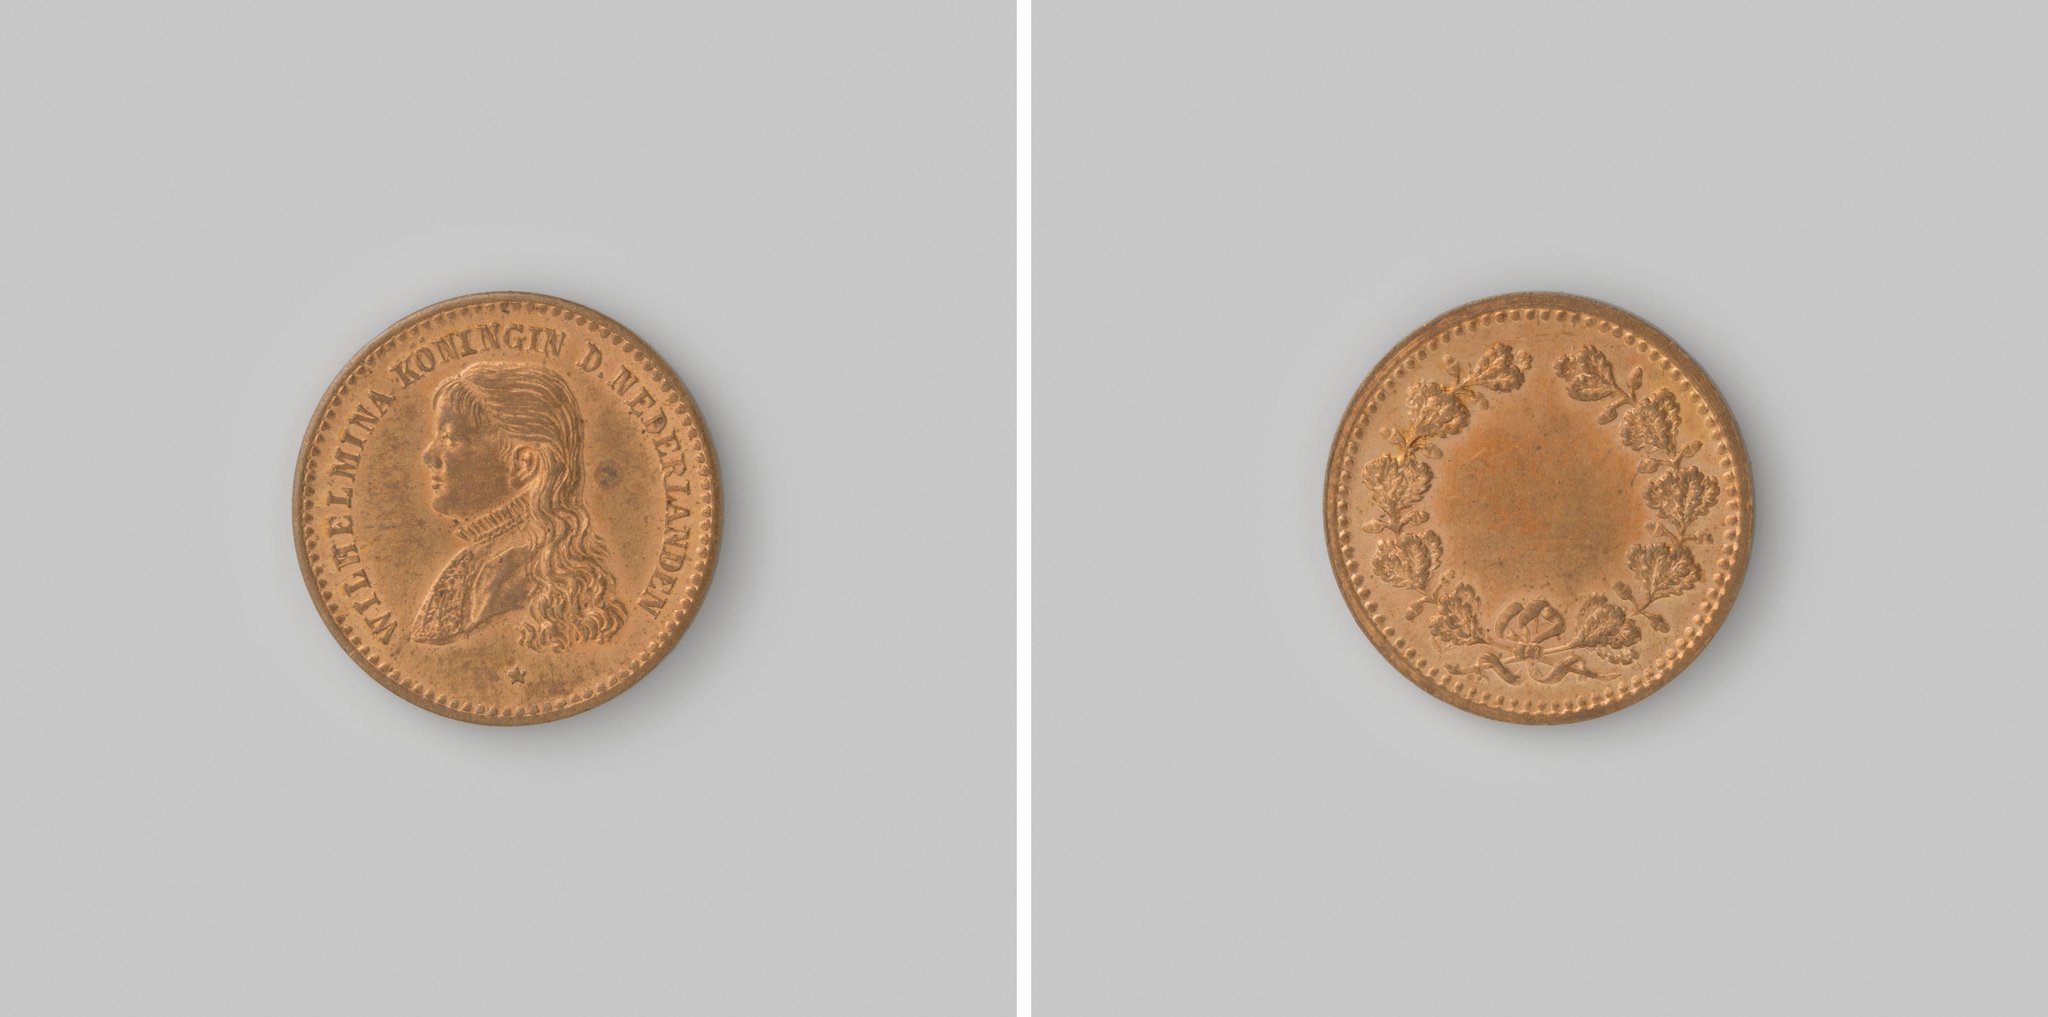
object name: history medal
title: Wilhelmina Koningin der Nederlanden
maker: wolfgang lauer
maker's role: medailleur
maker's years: 1856-1915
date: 1890-1898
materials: brass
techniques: striking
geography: nuremberg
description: Goudkleurig messing penninkje, op de voorzijde het portret van Wilhelmina met hangend haar, met omschrift, op de keerzijde twee samengestrikte eikentakken.